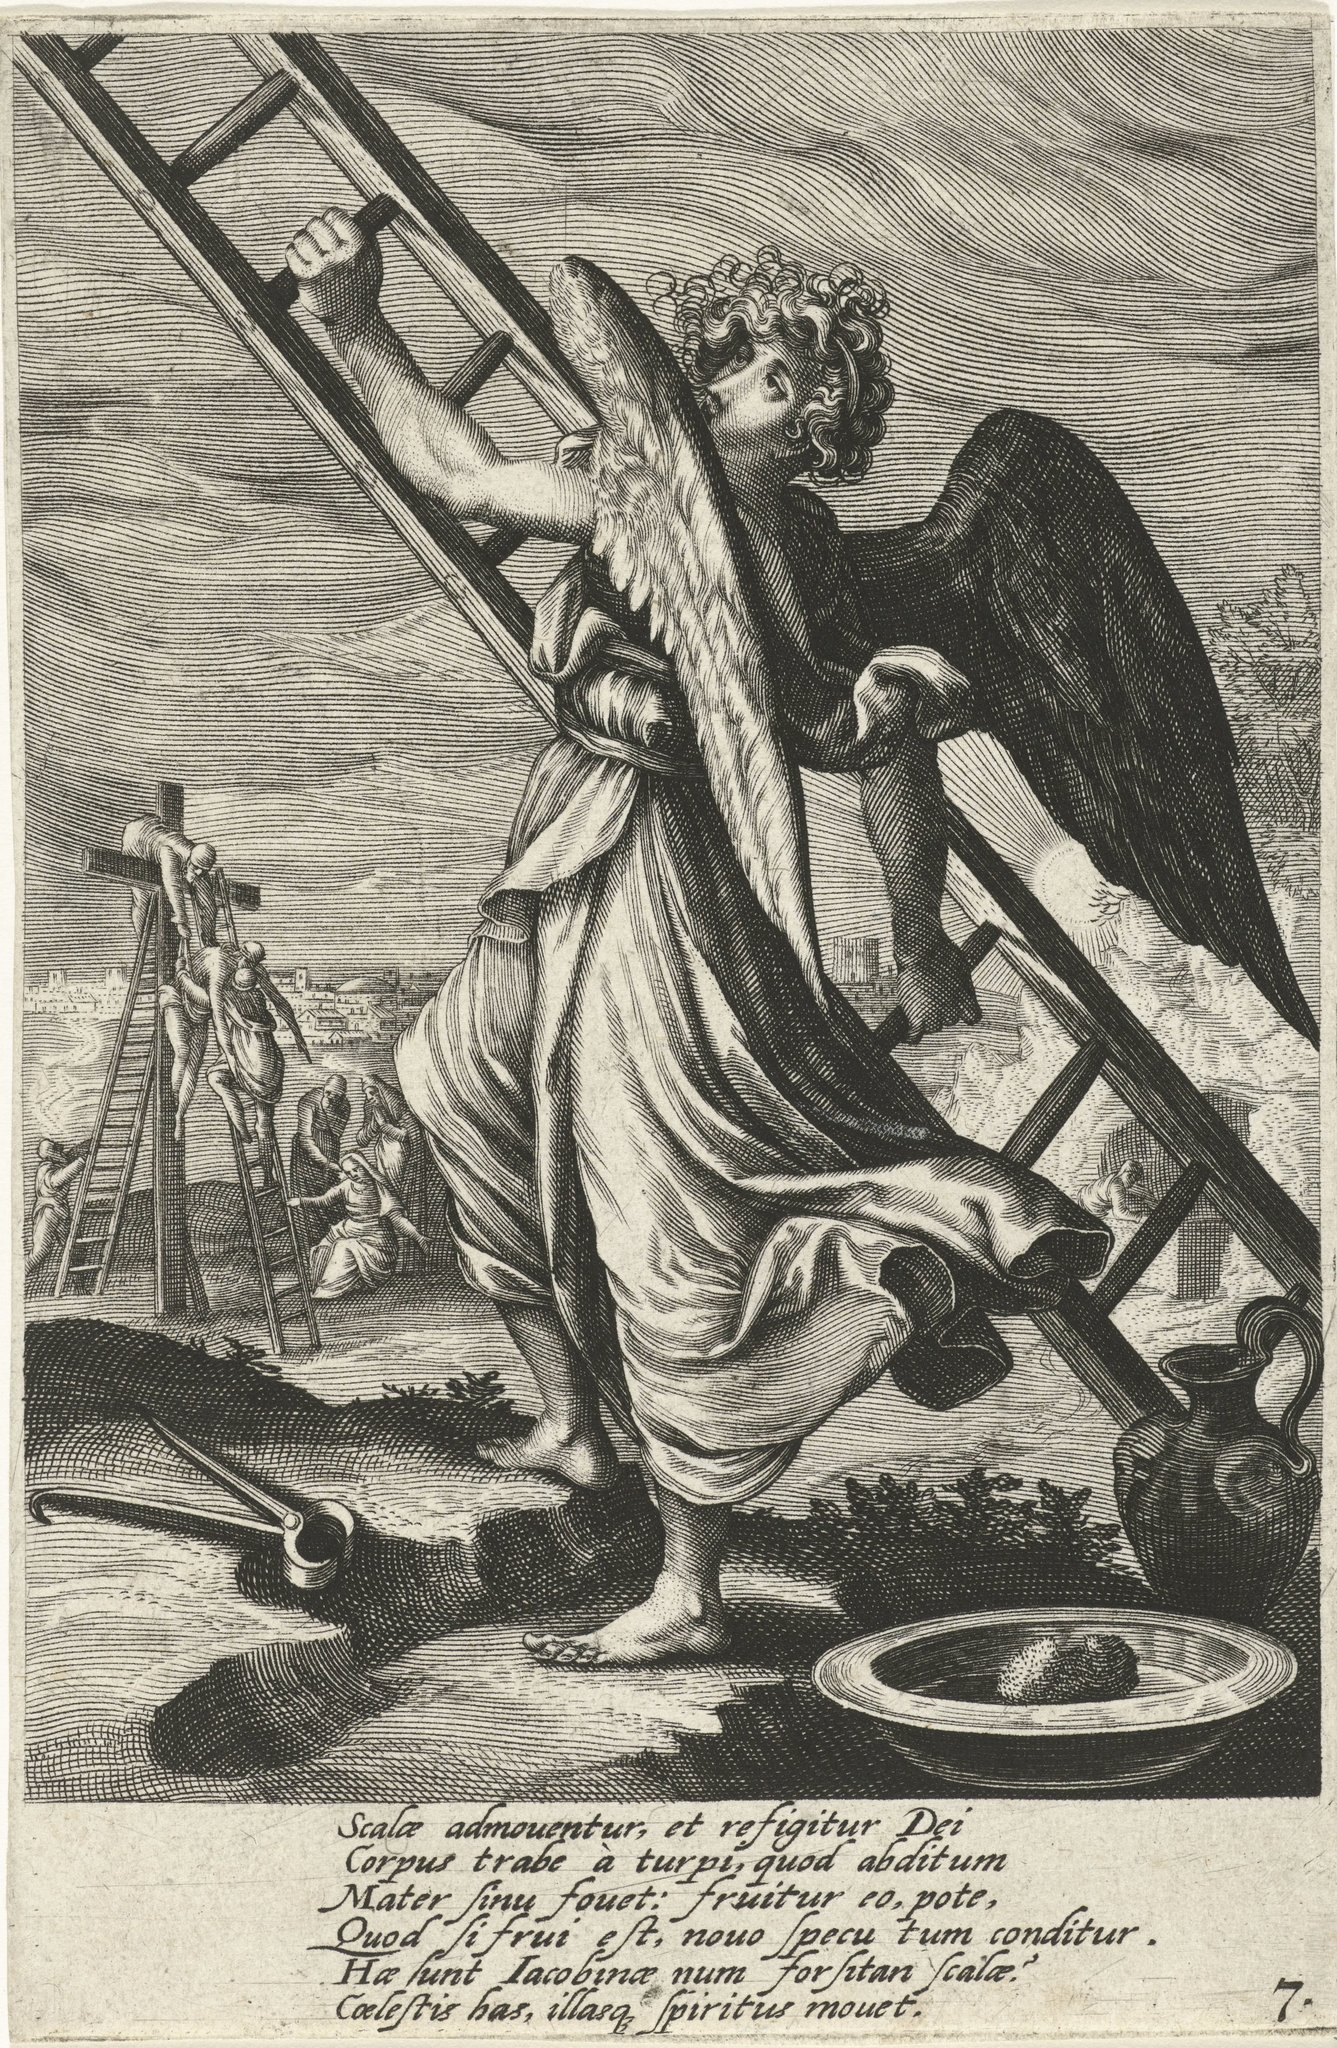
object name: print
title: Passiewerktuigen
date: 1608-1658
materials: paper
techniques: engraving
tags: descent from the cross: christ is taken down from the cross, usually by nicodemus and joseph of arimathaea who are standing on the ladders (both arms of christ detached), single instruments of the passion (with name), tools, aids, implements ~ crafts and industries: tongs, virtues (holding instruments of the passion) ~ hierarchy of angels, the instruments of the passion and the five wounded limbs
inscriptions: collector's mark: Lugt 3791, collector's mark: Lugt 2228, collector's mark: Lugt 2760, collector's mark: Lugt 1041c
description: Op de voorgrond een engel die een ladder draagt. Op de grond een nijptang en een kruik en wasbekken waarin een spons. Op de achtergrond de kruisafname.